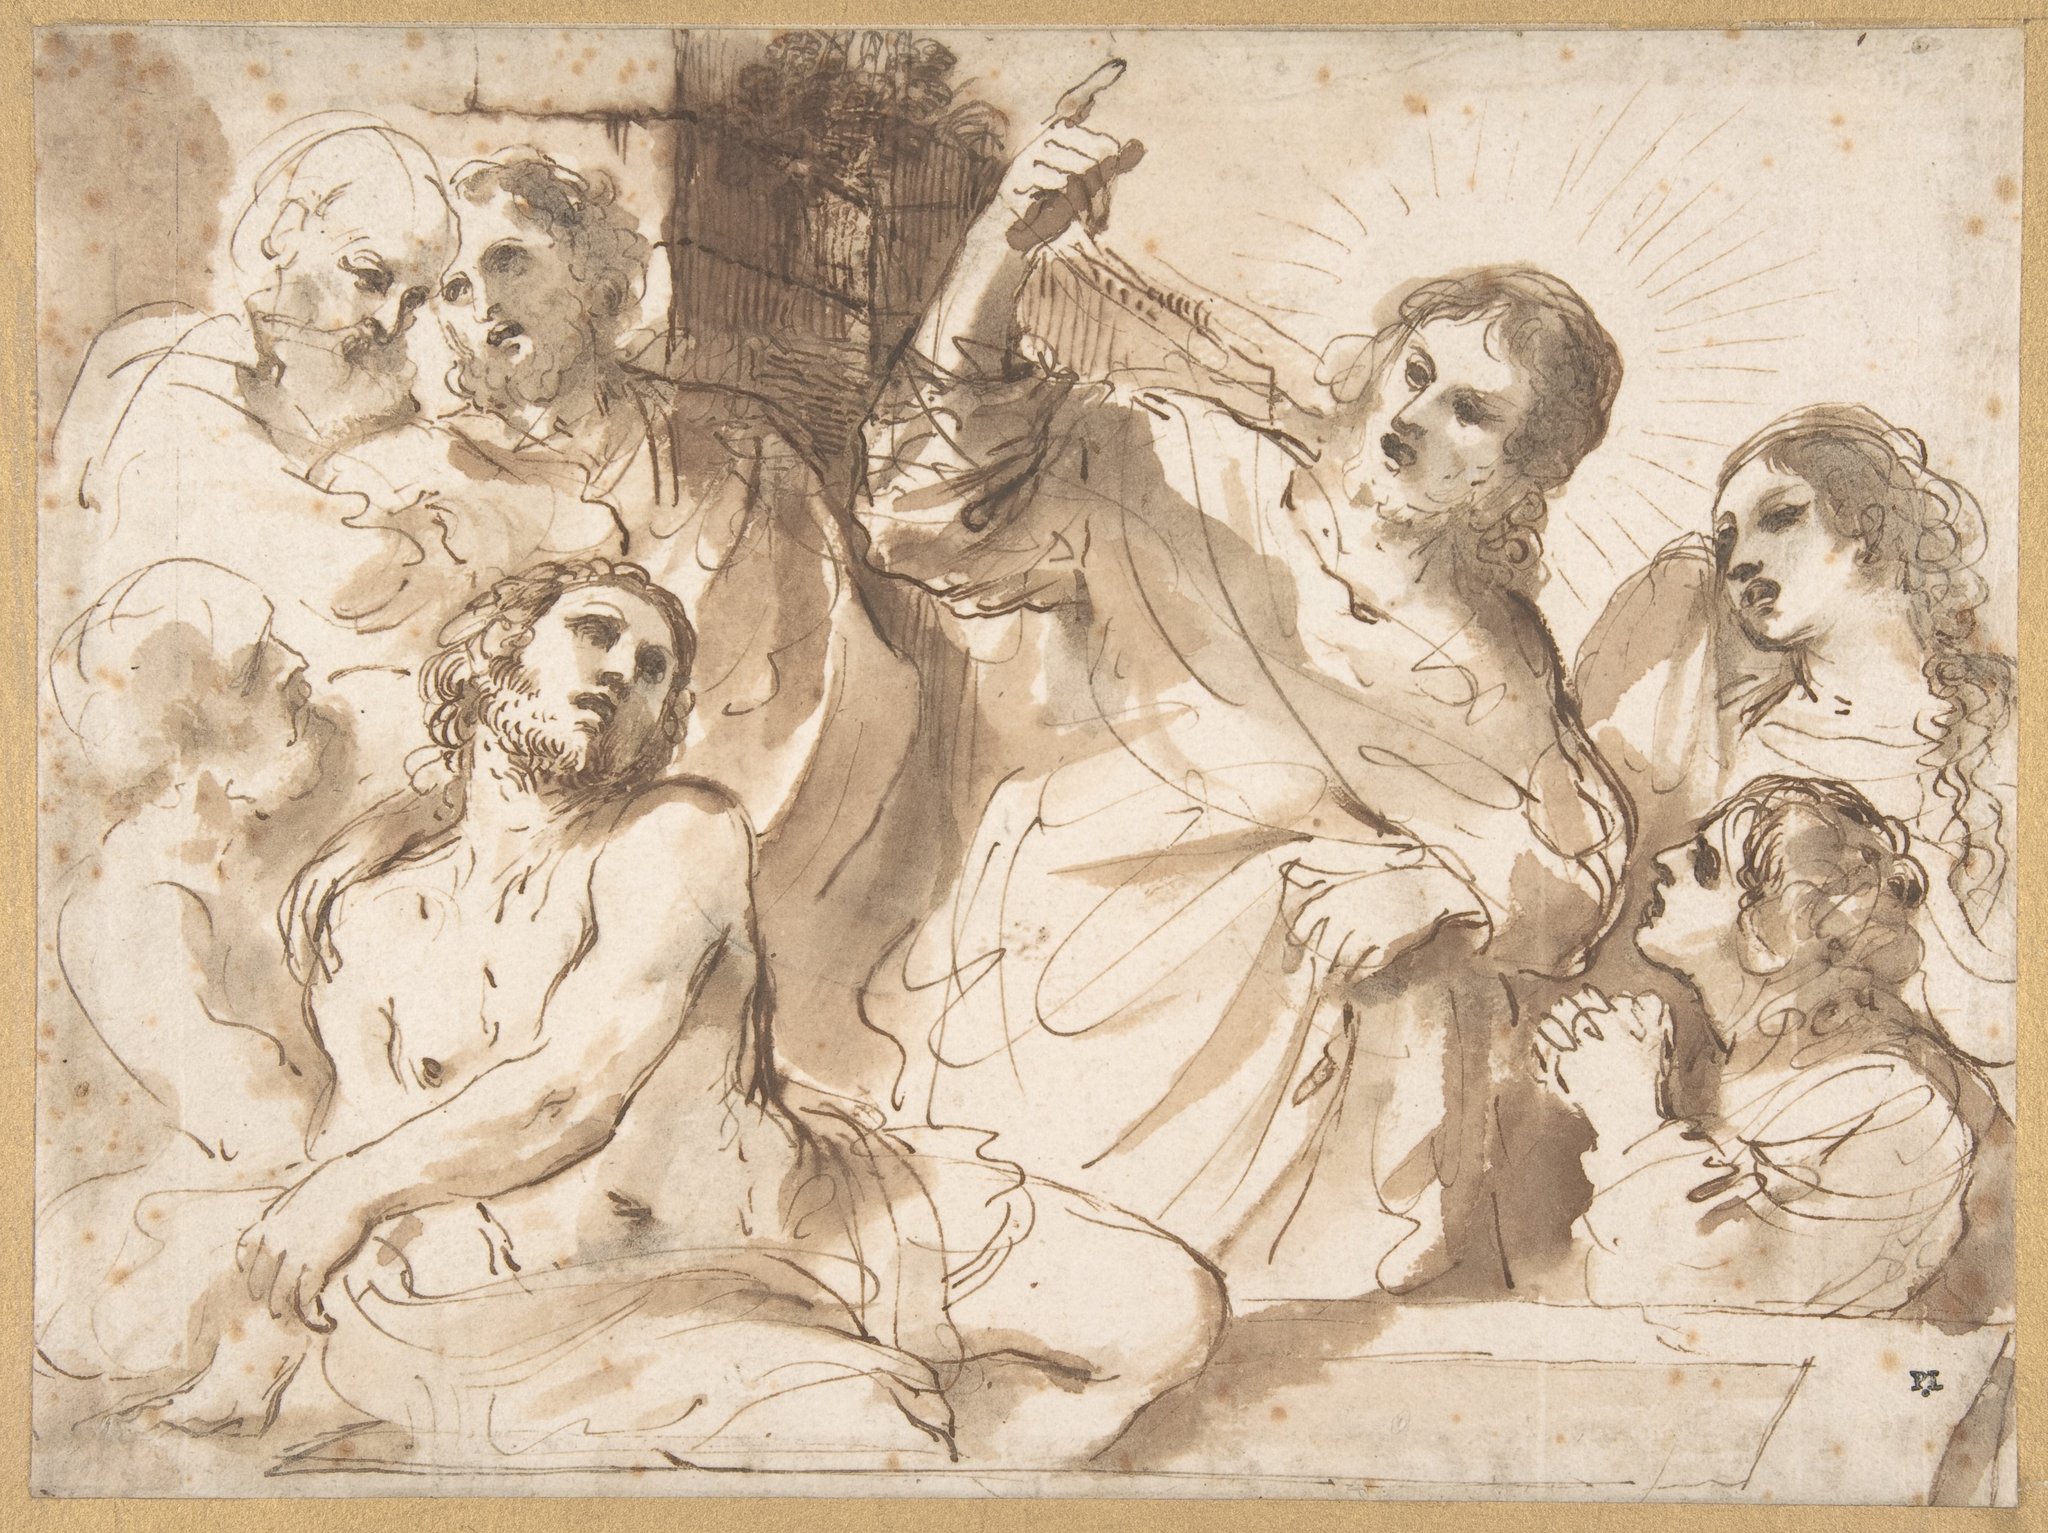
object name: drawing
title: The Raising of Lazarus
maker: guercino (giovanni francesco barbieri)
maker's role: artist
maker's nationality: italian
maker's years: 1591-1666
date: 1619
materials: chalk, ink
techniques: brush, pen, wash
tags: men,saints